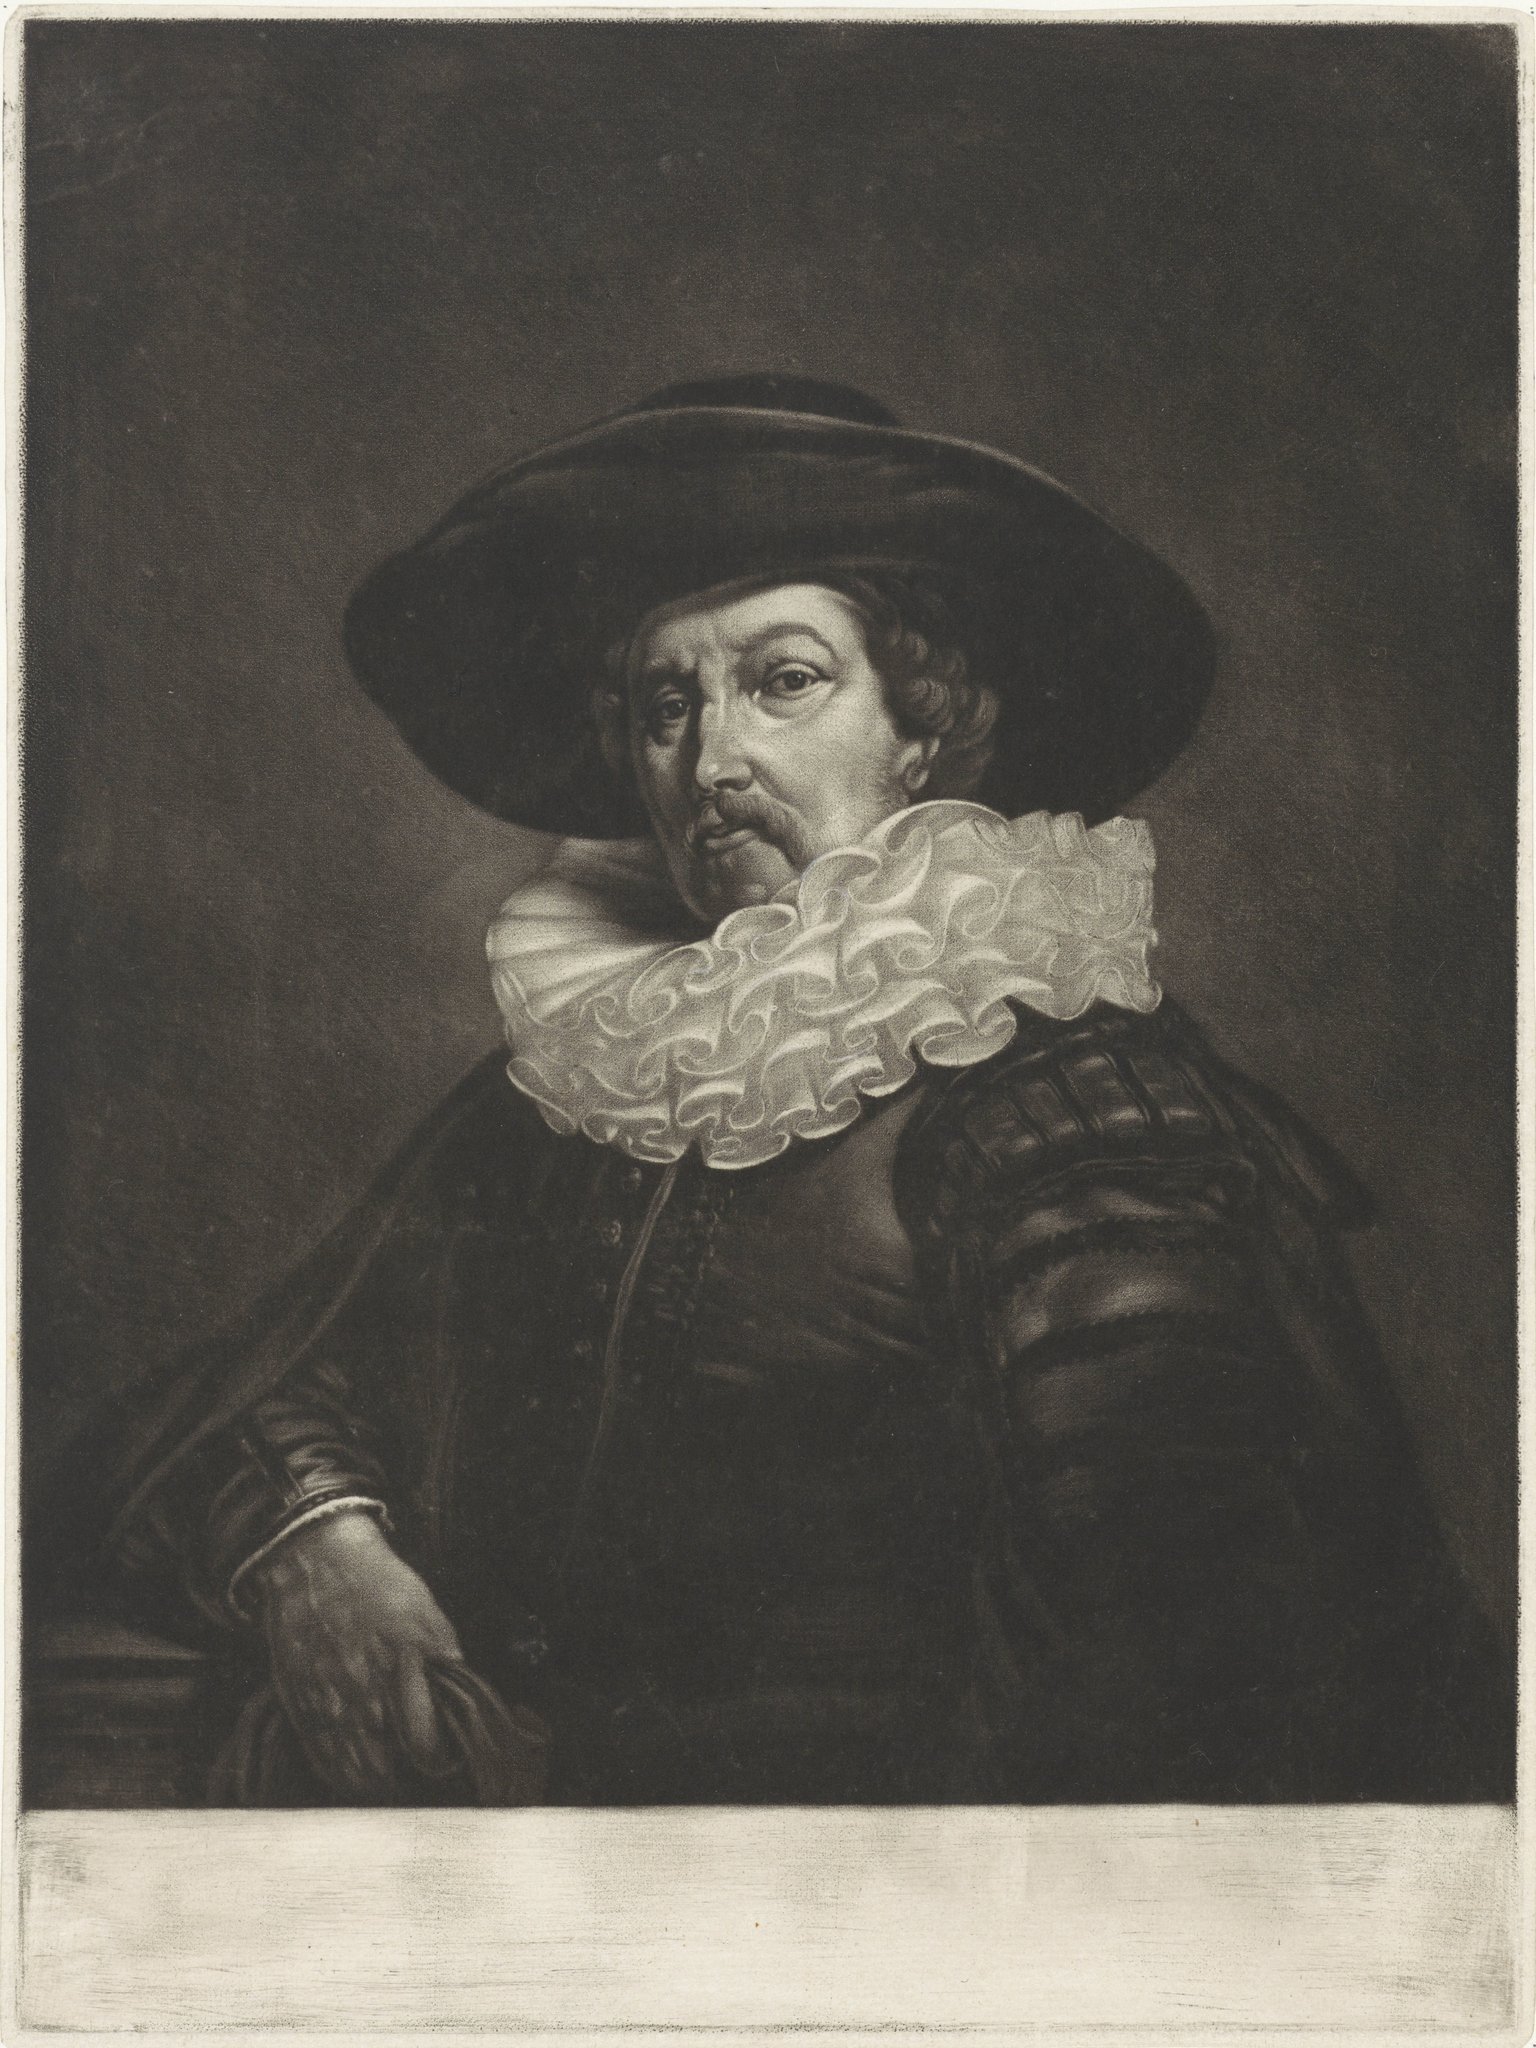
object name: print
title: Portret van Jacob van Mosscher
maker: jan stolker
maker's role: draughtsman, painter, print maker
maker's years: 1724-1785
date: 1734-1785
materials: paper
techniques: mezzotint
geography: northern netherlands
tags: jacob van mosscher, gloves, mittens, etc., head-gear: hat (+ men's clothes), portrait, self-portrait of painter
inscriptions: collector's mark: Lugt 240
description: De schilder Jacob van Mosscher met zijn handschoenen in de hand. Hij draagt een hoed.